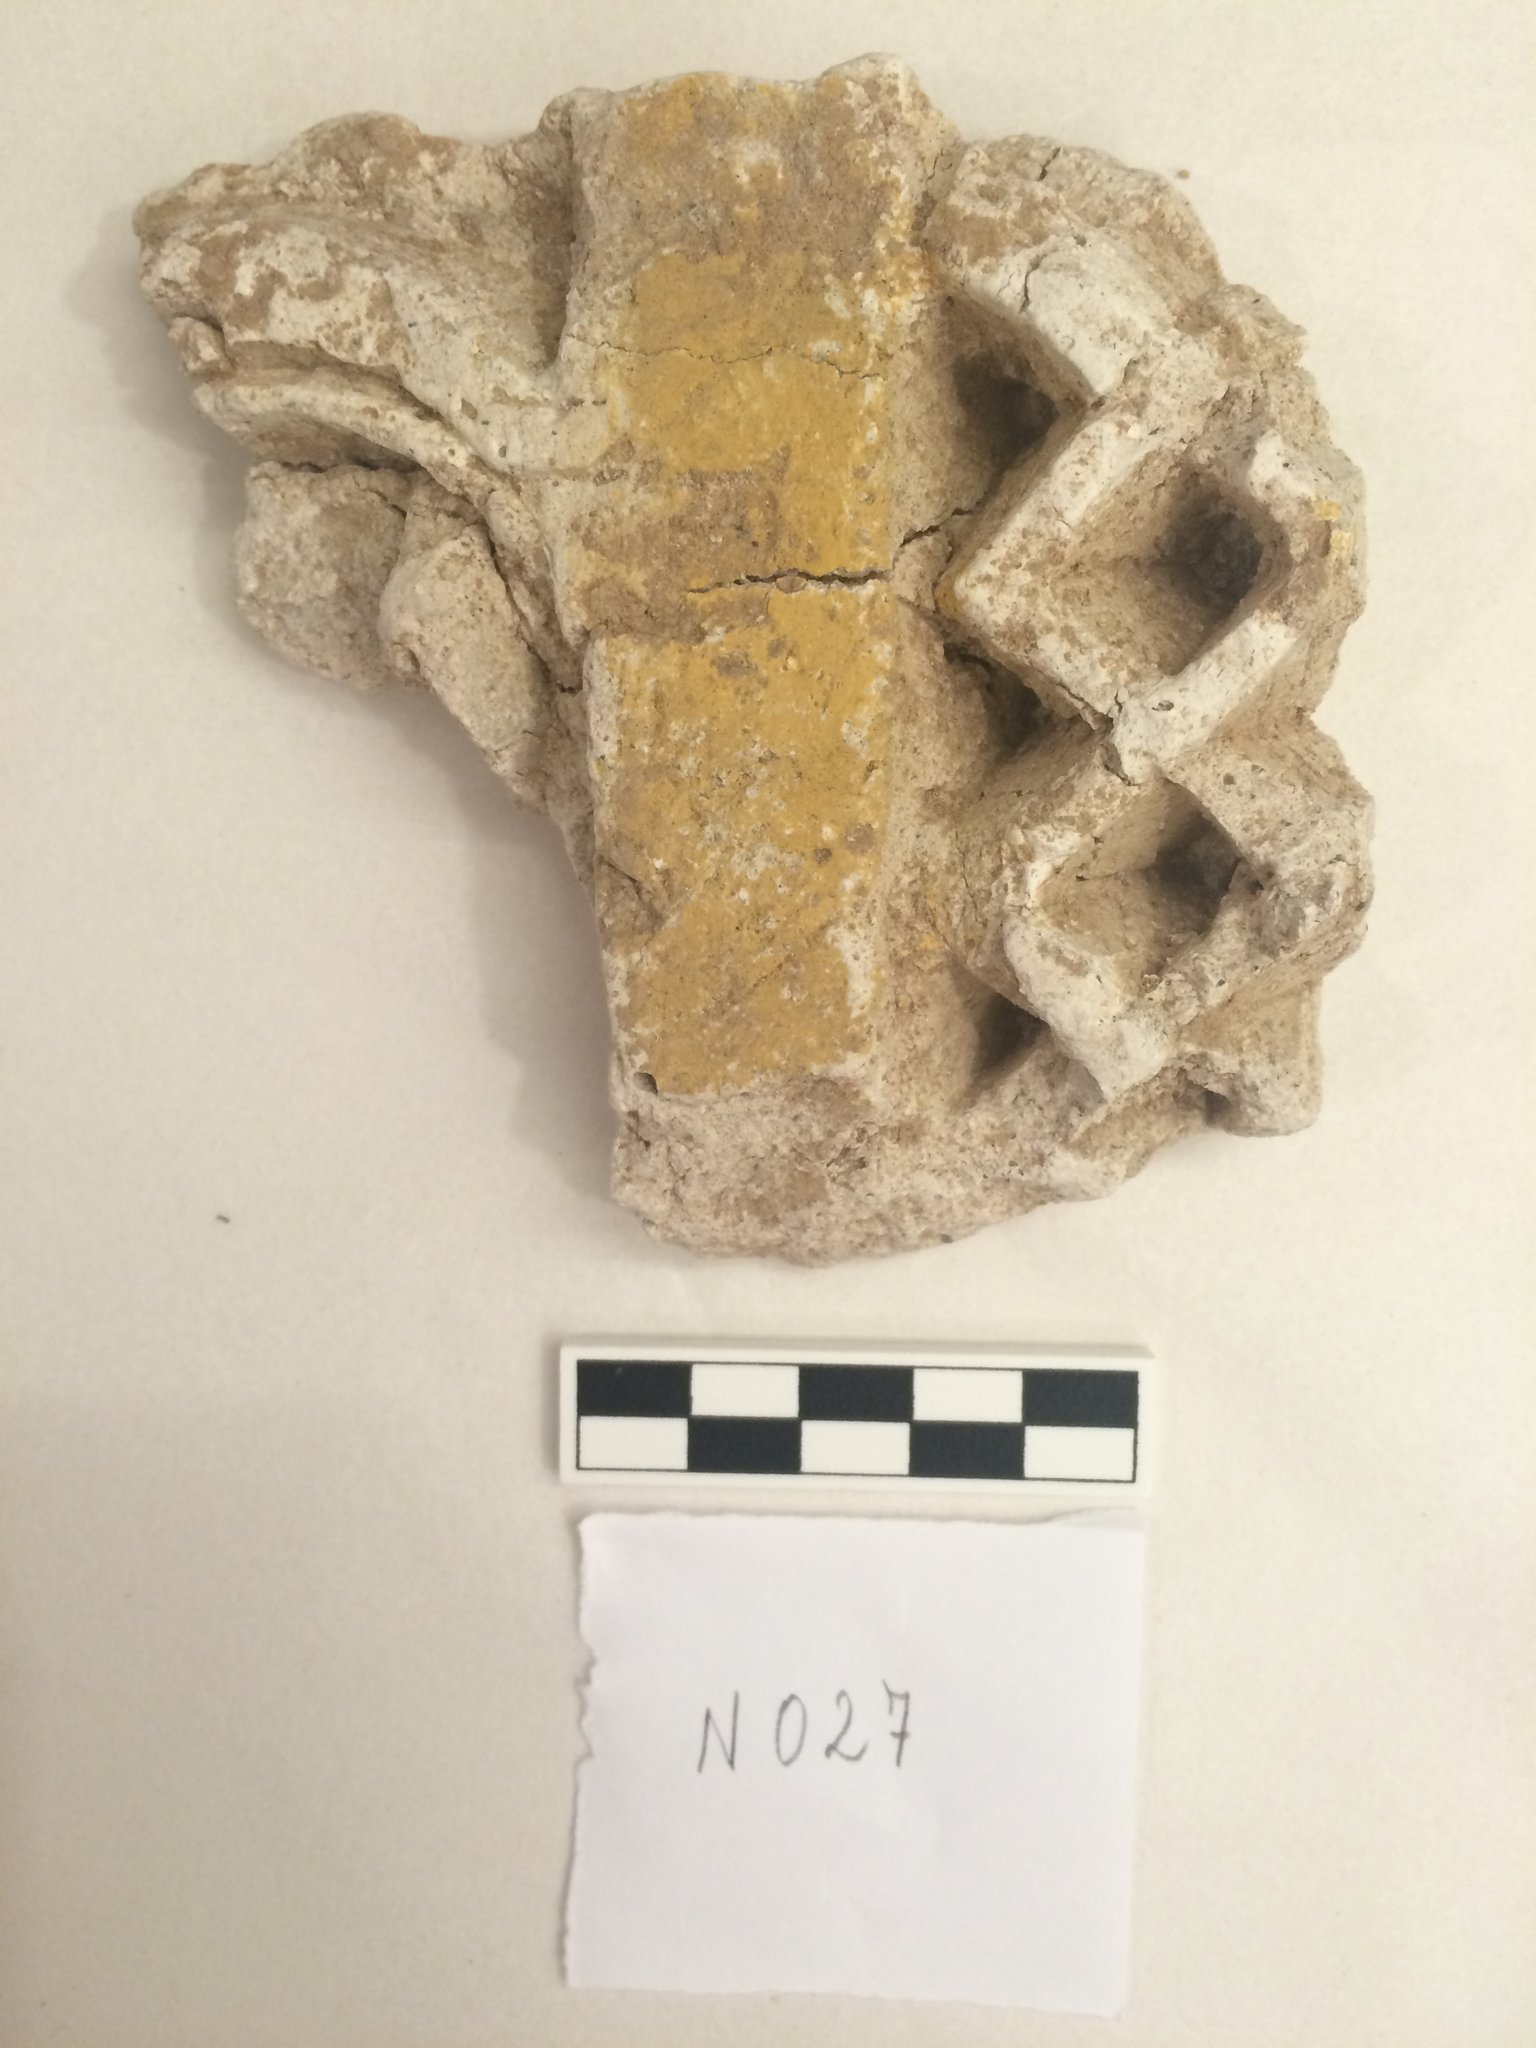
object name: fragment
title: Stucco Fragment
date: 701-1200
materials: plaster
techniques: carving, painting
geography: iran